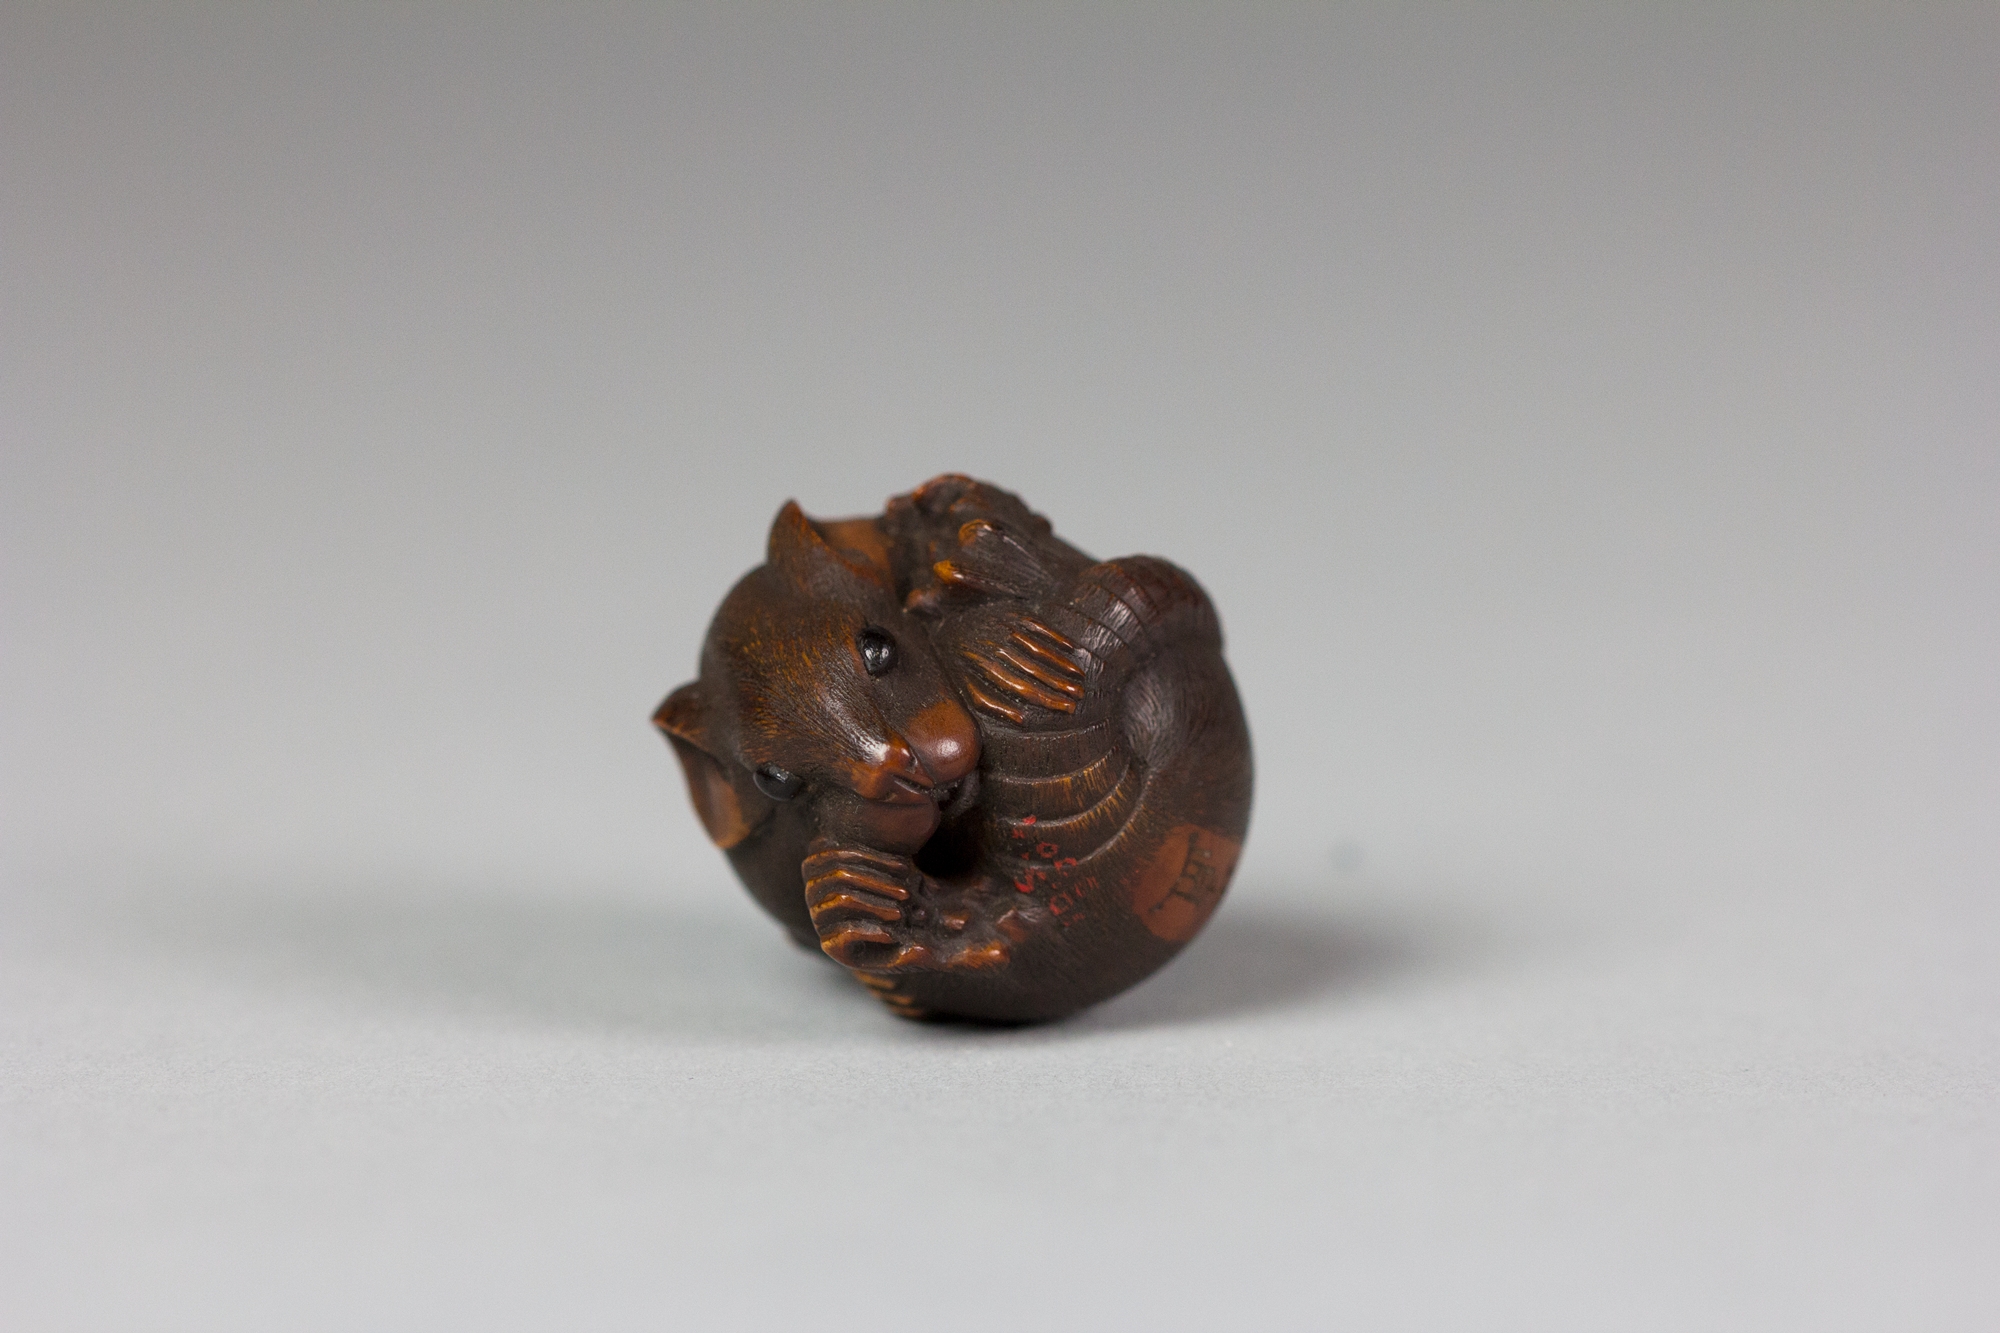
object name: netsuke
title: Netsuke of Mouse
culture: japanese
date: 1701-1800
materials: wood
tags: mice